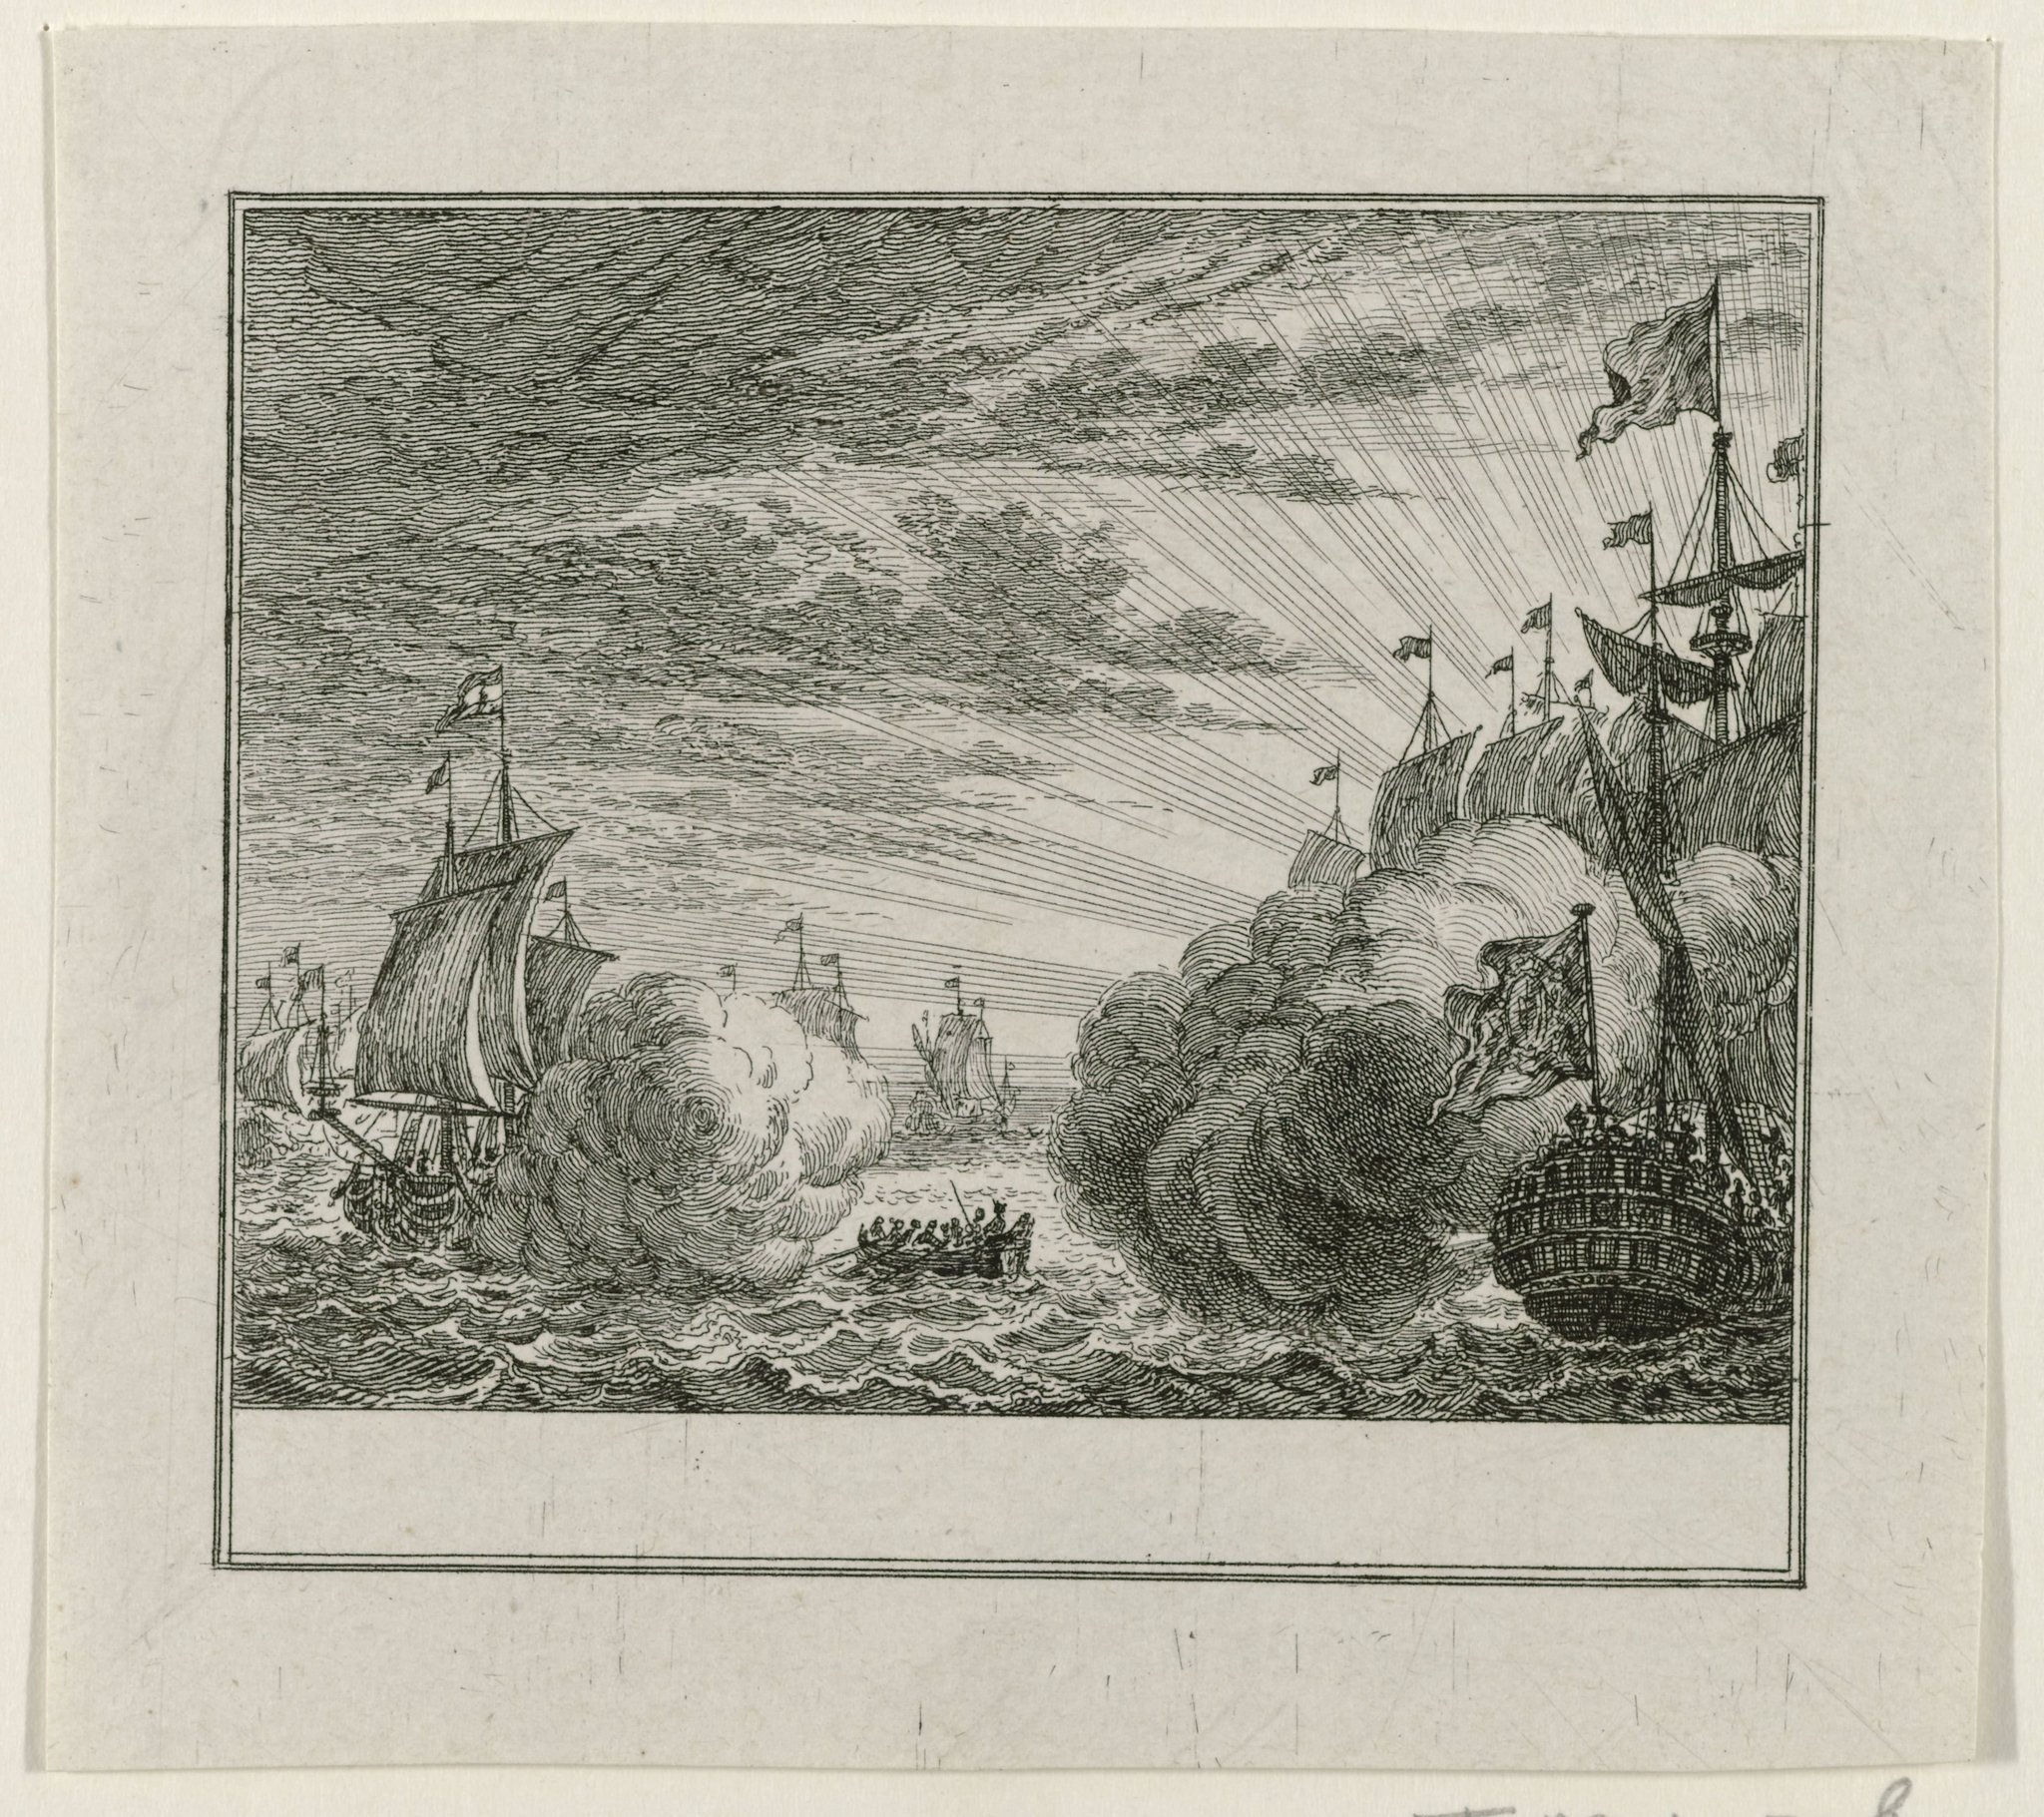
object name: print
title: Treffen tussen Fielding en Van Bylandt, 1779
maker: simon fokke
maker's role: draughtsman, print maker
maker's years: 1712-1784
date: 1779-1784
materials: paper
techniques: engraving, etching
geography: northern netherlands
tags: battle (+ naval force)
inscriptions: collector's mark: Lugt 2228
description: Treffen tussen een Engels eskader onder bevelhebber Charles Fielding en een Nederlands eskader onder Lodewijk van Bylandt dat een konvooi begeleidde, bij Isle of Wight op 31 december 1779.